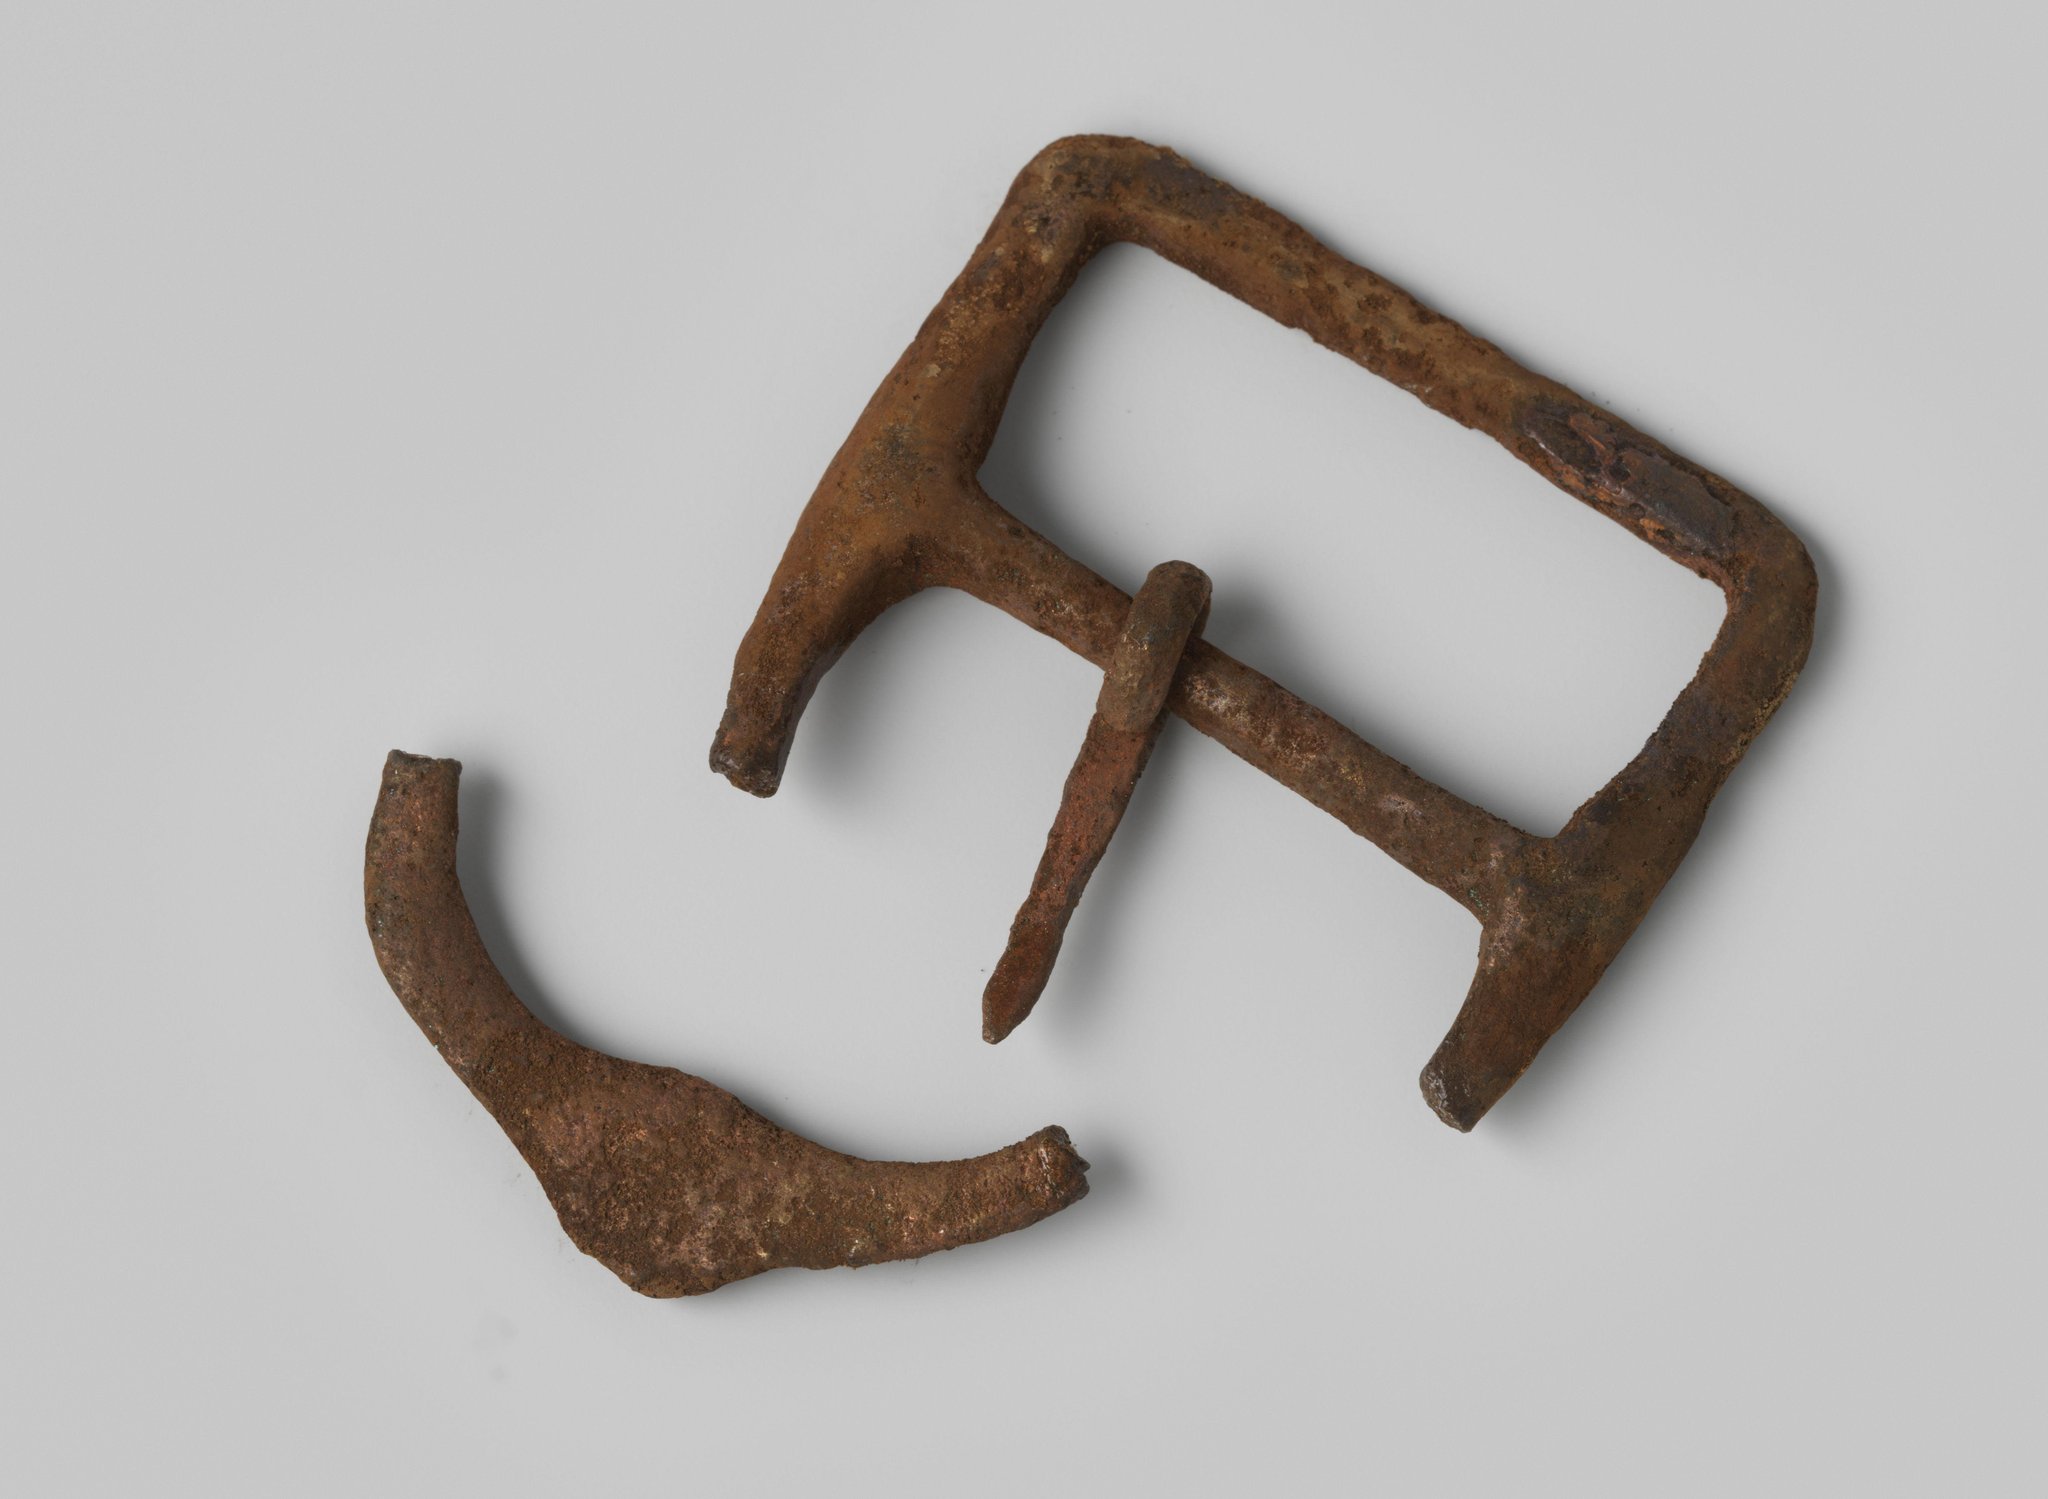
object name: belt buckle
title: Fragmenten riemgesp uit het wrak van de Oost-Indiëvaarder Hollandia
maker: Anonymous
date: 1700-1743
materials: copper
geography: netherlands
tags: verenigde oostindische compagnie, hollandia (schip), annet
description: D-shaped with pointed side, fragm, id. NG 1980-27H384, belt buckle.